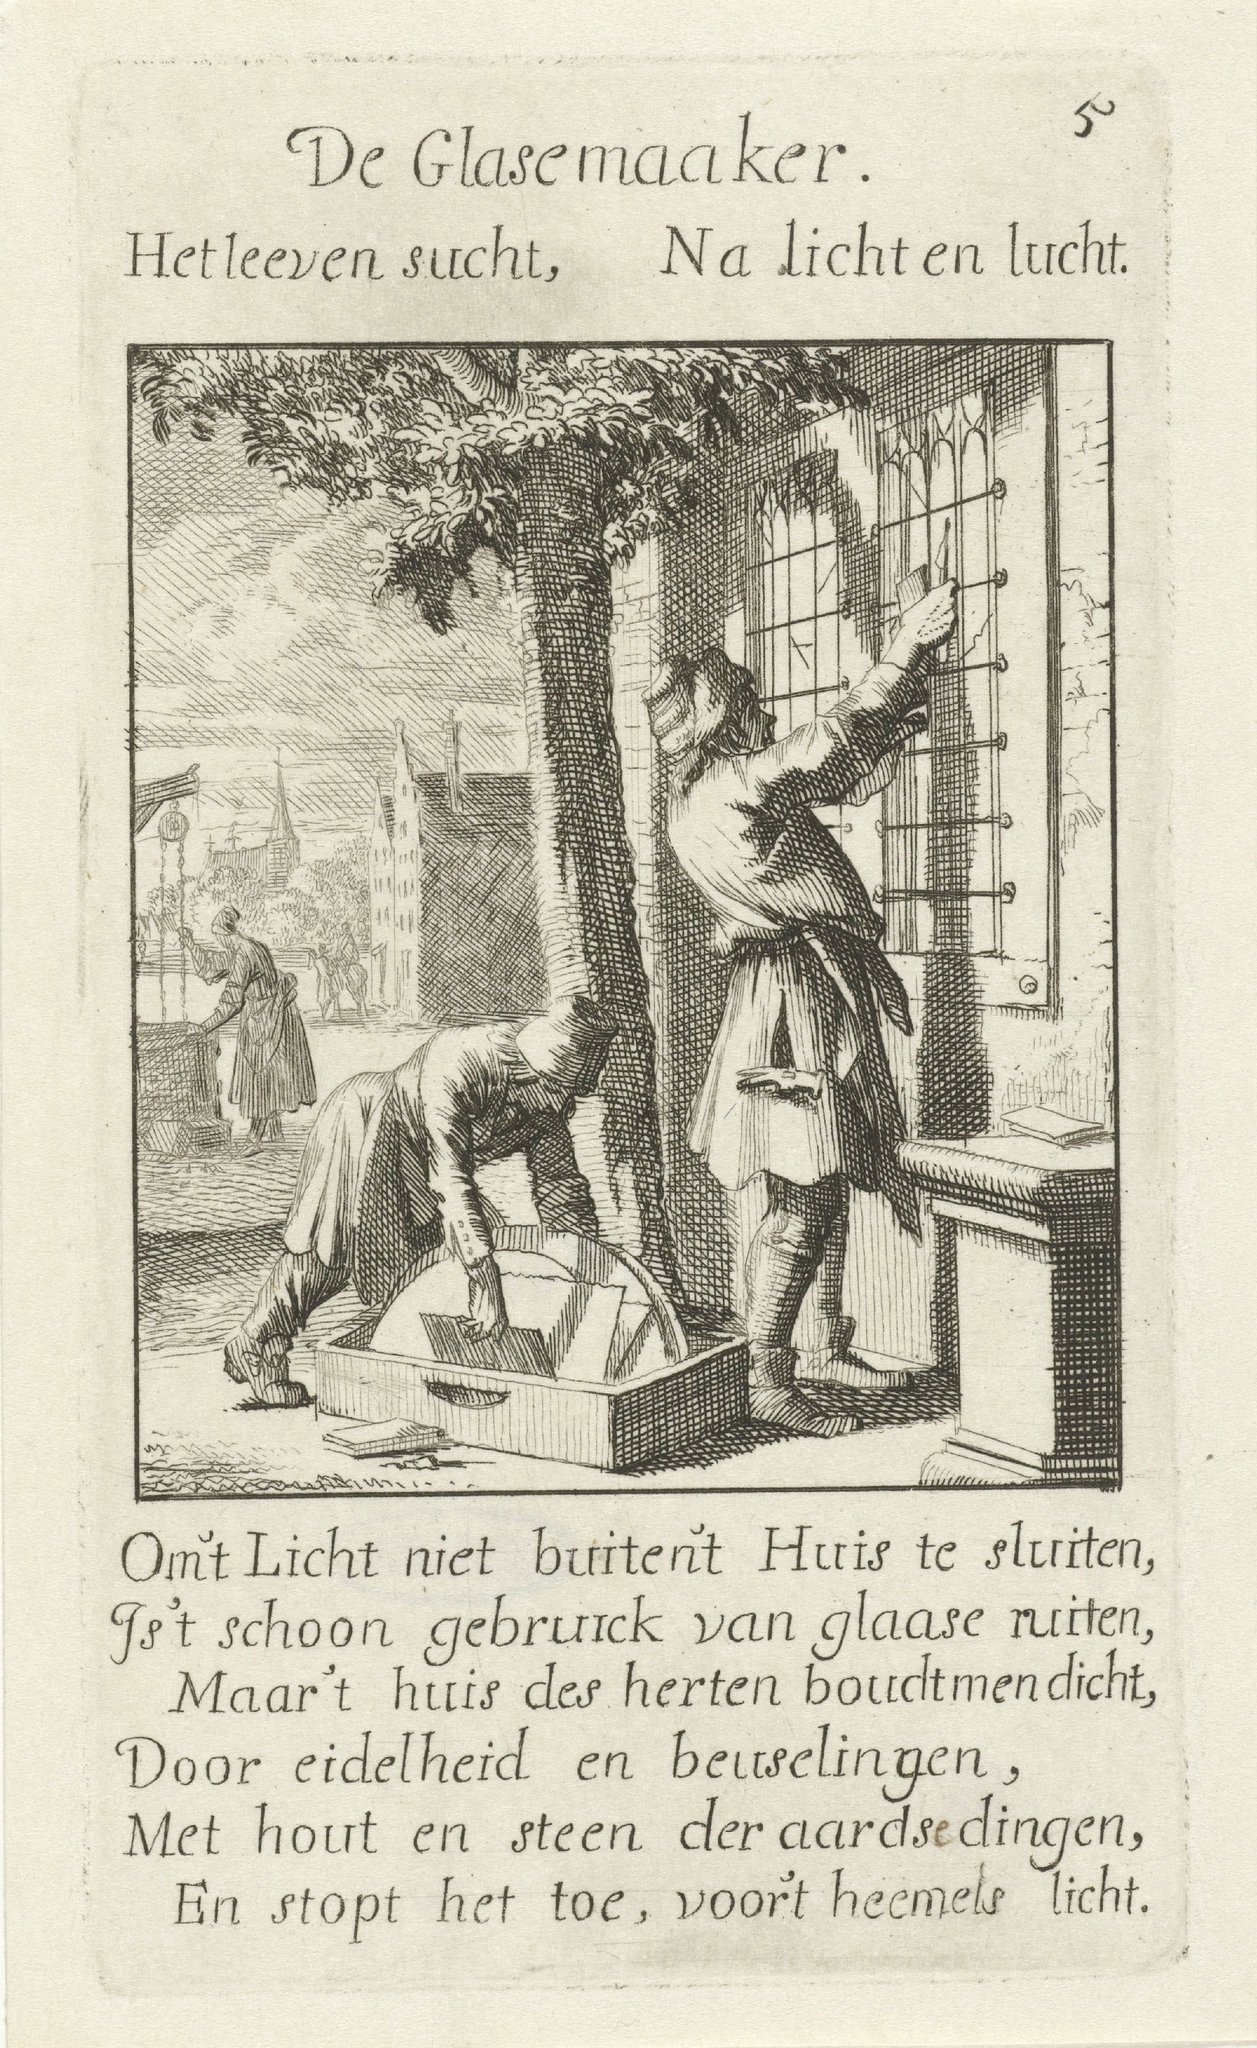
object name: print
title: Glaszetter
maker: jan luyken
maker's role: draughtsman, print maker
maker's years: 1649-1712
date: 1694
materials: paper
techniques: etching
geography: amsterdam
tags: glazing (window panes, leaded lights, etc.), glazier at work, handicrafts, craftsman at work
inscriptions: collector's mark: Lugt 2760, collector's mark: Lugt 2228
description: Maakt deel uit van de 100-delige serie beroepsprenten van Jan en Caspar Luyken, getiteld: Het menselyk bedryf. S.l.s.n., 1694 (eerste druk).